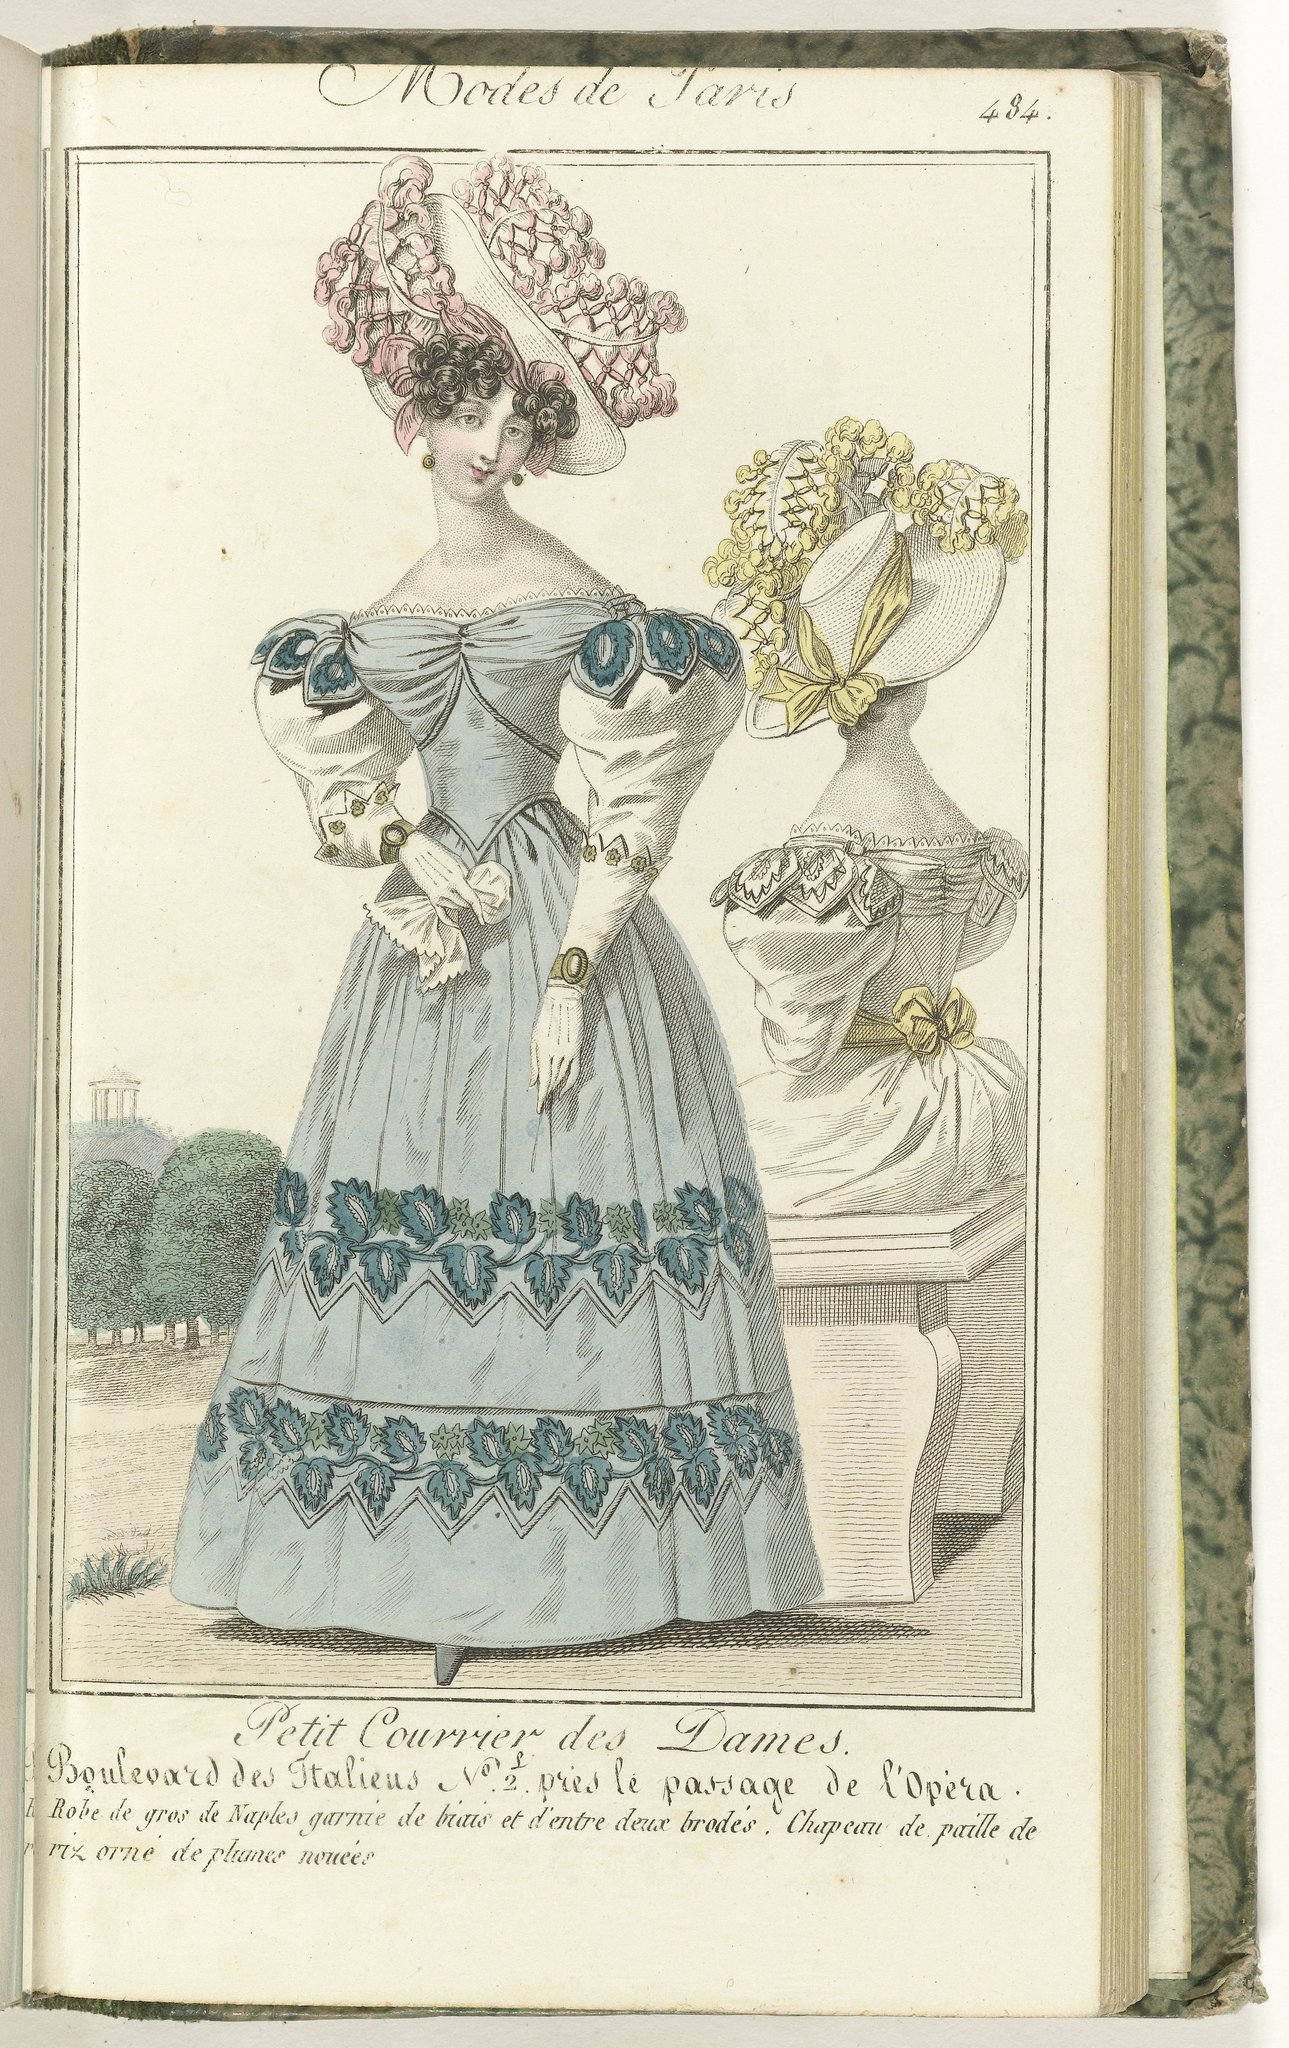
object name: fashion print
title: Petit Courrier des Dames, 15 juillet 1827, No. 484 : Robe de gros de Naples...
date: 1827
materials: paper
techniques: engraving, hand coloring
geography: paris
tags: handkerchief (+ women's clothes), ornamental parts of clothing (+ women's clothes), embroidery (ornamentation) (+ women's clothes), fashion plates, head-gear: hat (+ women's clothes), dress, gown (+ women's clothes), bracelet, wristlet (+ women's clothes)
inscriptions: title: ‘Modes de Paris.’, caption: ‘Robe de gros de Naples, garnie de biais et d'entre deux brodés. Chapeau de paille de riz orné de plumes nouées’, address: ‘Boulevard des Italiens No.2 près le passage de l'Opèra.’, title: ‘Petit Courrier des Dames.’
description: Staande vrouw gekleed in een japon van 'gros de Naples' gegarneerd met een biais en geborduurde entre-deux. Op het hoofd een hoed van paille de riz versierd met geknoopte veren. Zittende figuur in eenzelfde japon, op de rug gezien. Prent uit het modetijdschrift Petit Courrier des Dames (1821-1868). Ingebonden (met enkele pp. Le Journal des Dames et des Modes). 15 Januari 1827 t/m 20 maart 1830. Incompleet.